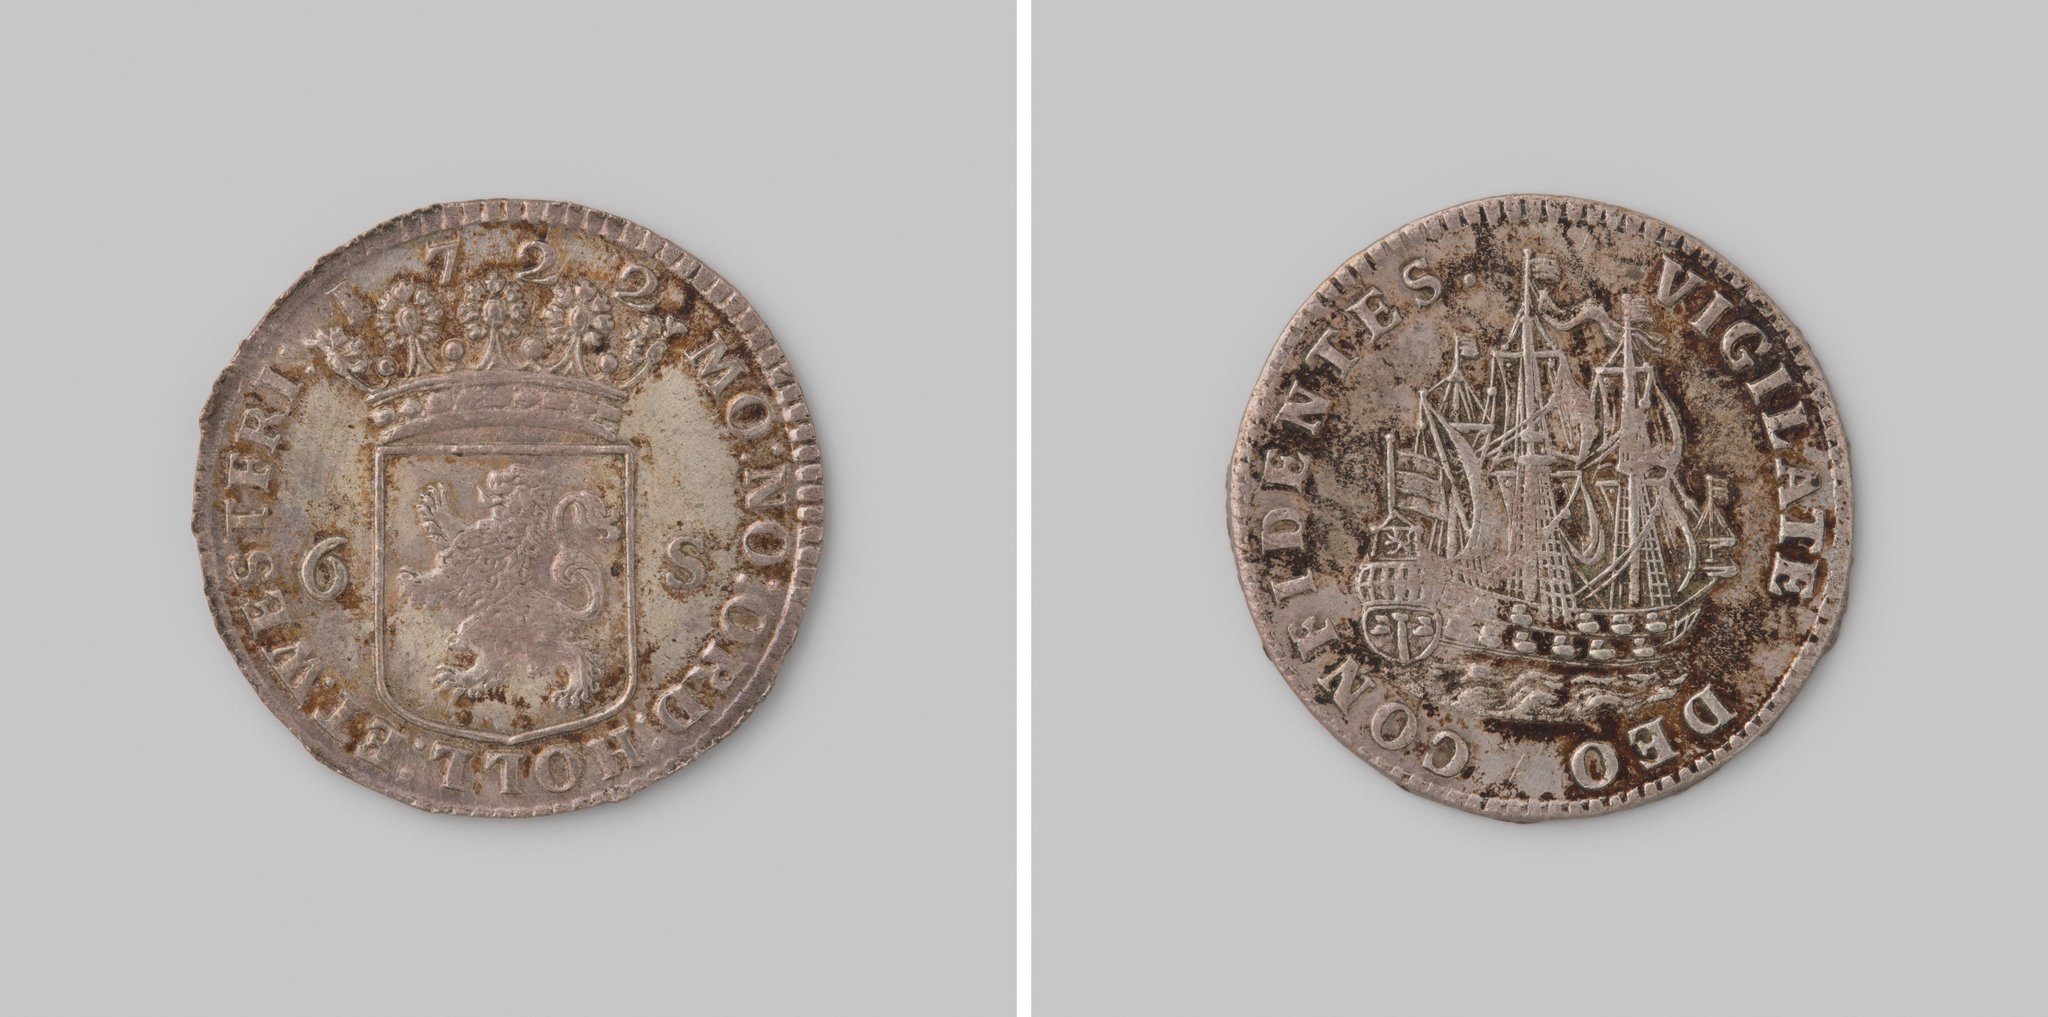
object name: coin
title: Holland, scheeepjesschelling, 1722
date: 1722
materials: silver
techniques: striking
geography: dordrecht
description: Zilveren munt. Voorzijde: tussen waarde-aanduiding 6 S gekroond wapenschild van Holland. Jaartal boven kroon. Keerzijde: oorlogsschip, varend naar rechts.